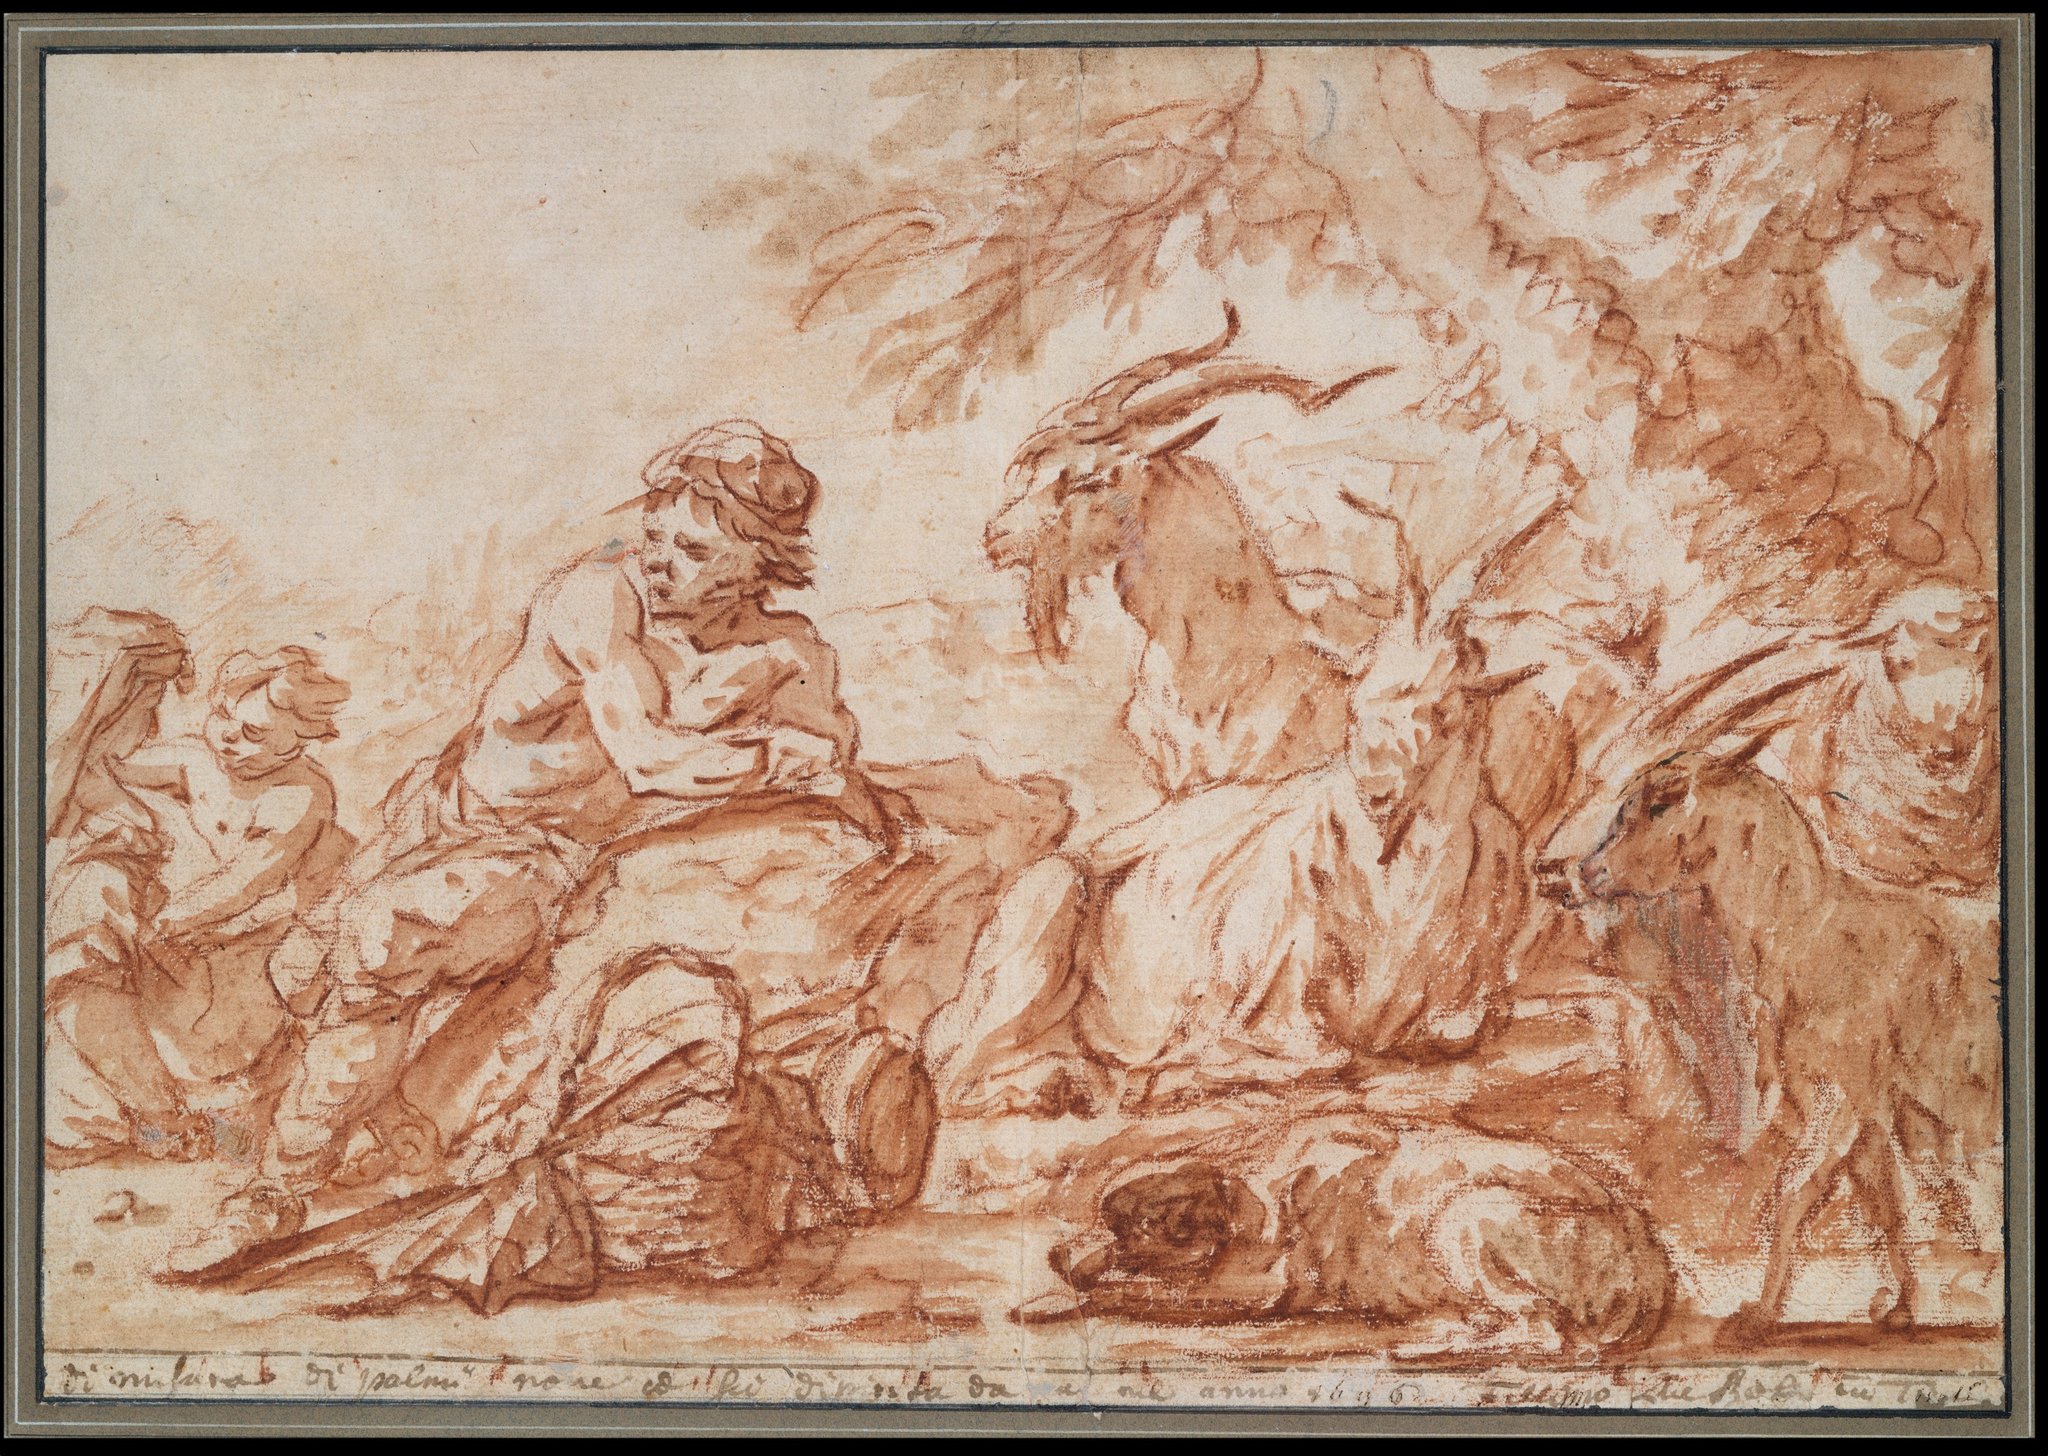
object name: drawing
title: Pastoral Scene: A Herdsman and His Family, with Goats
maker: philipp peter roos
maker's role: artist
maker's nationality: german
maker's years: 1657-1706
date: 1667-1733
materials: chalk, ink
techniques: brush, pen, wash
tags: children,men,women,dogs,goats,family